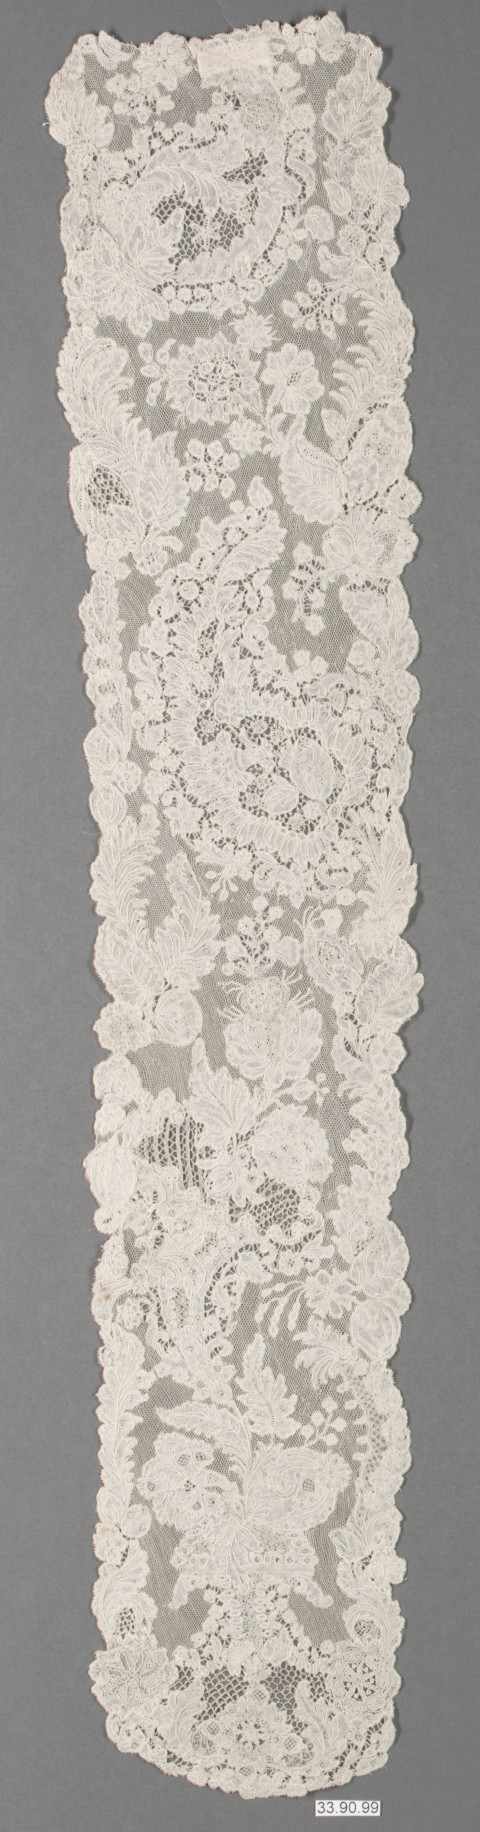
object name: lappet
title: Lappet (one of a pair)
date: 1701-1800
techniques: lace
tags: flowers